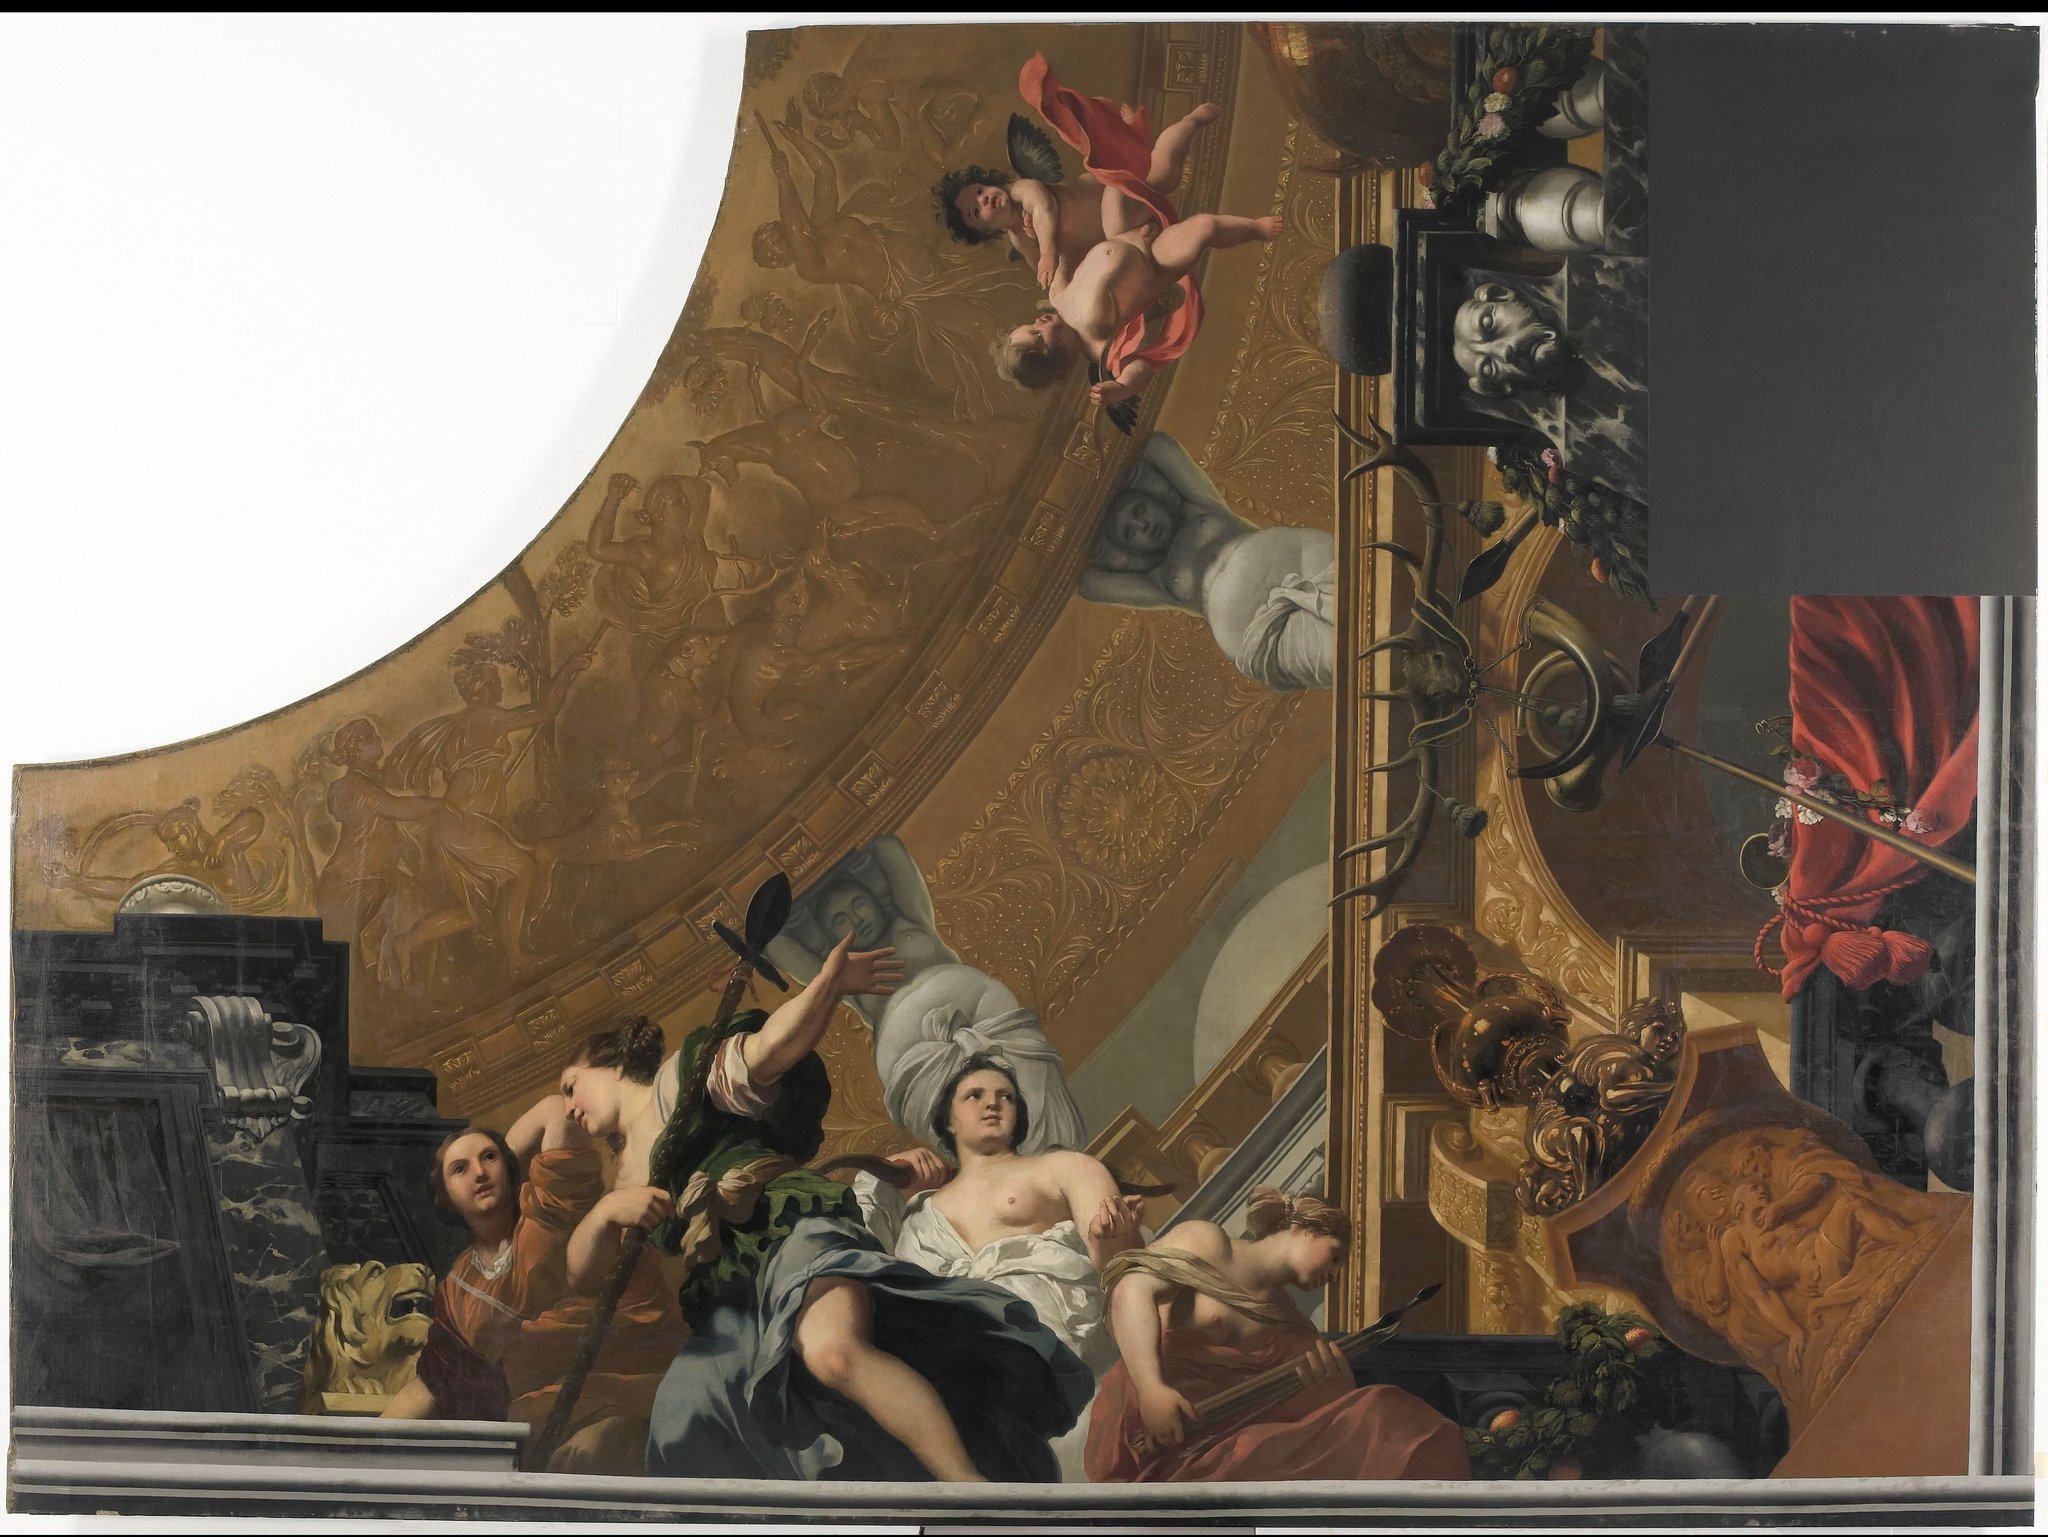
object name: painting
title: Part (bottom right) of a ceiling decoration with Diana and her companions as the principal representation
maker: gerard de lairesse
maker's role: draughtsman, painter, print maker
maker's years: 1641-1711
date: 1676-1682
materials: canvas, oil, paint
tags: (story of) diana (artemis)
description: Onderdeel (rechtsonder) van een plafondschildering van vijf delen met als hoofdvoorstelling Diana en haar gezellinnen, geschilderd voor de 'grote zaal' van Paleis Soestdijk.